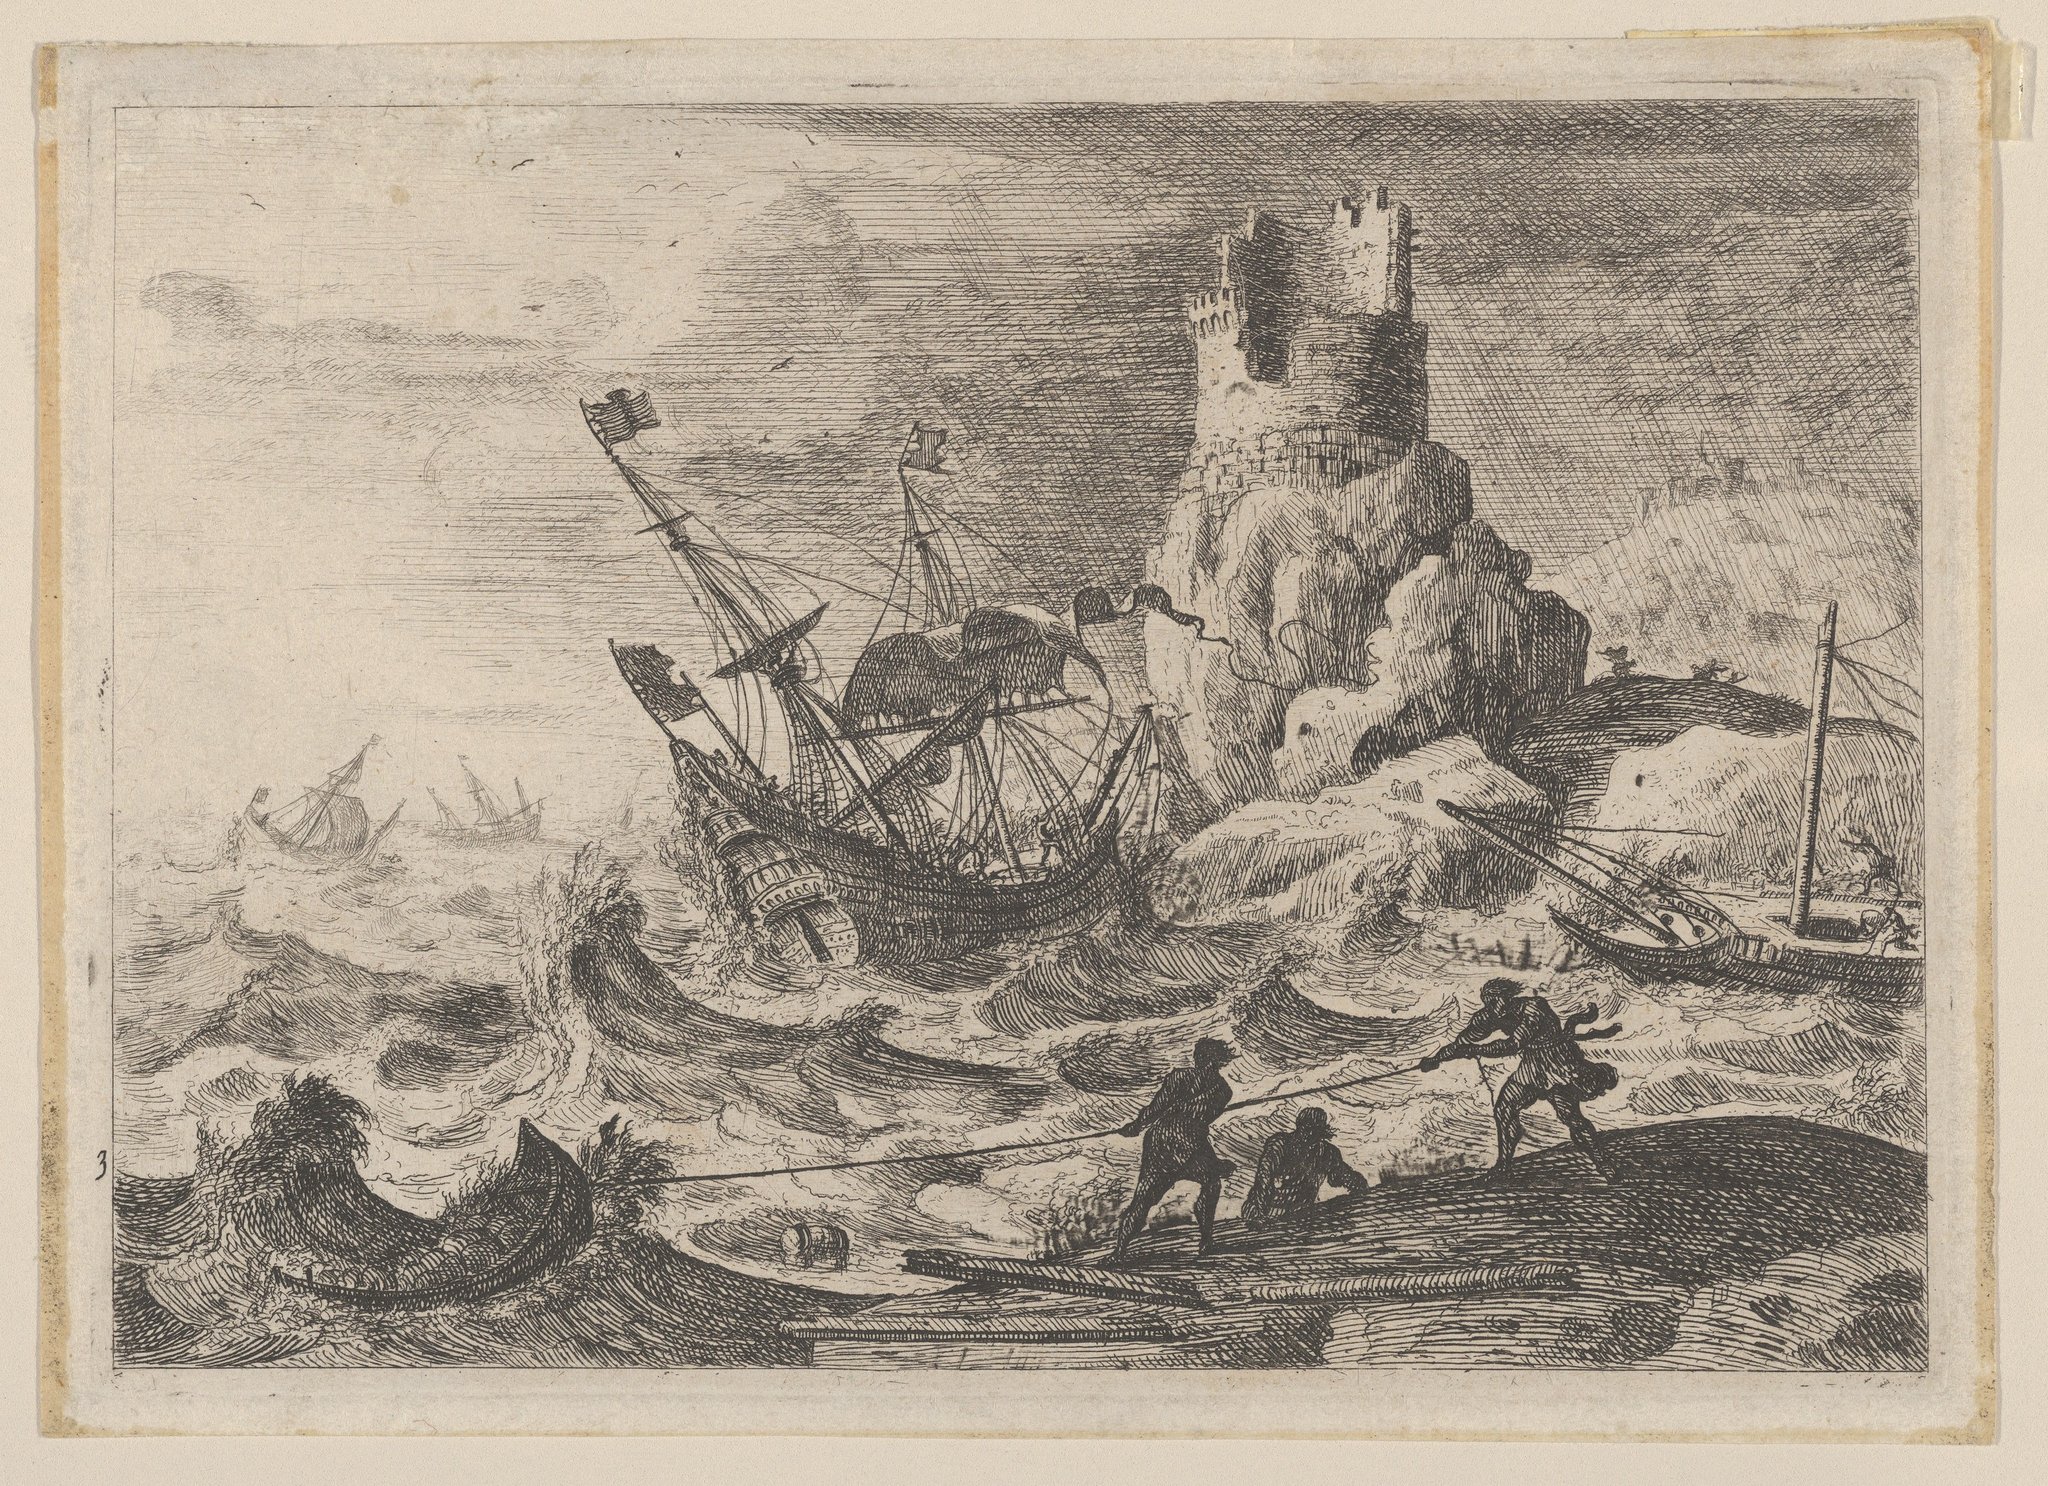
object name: print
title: The Shipwreck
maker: claude lorrain (claude gellée)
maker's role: artist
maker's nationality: french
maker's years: 1604-1682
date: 1638-1641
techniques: etching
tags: human figures,ruins,shipwrecks,waves,storms